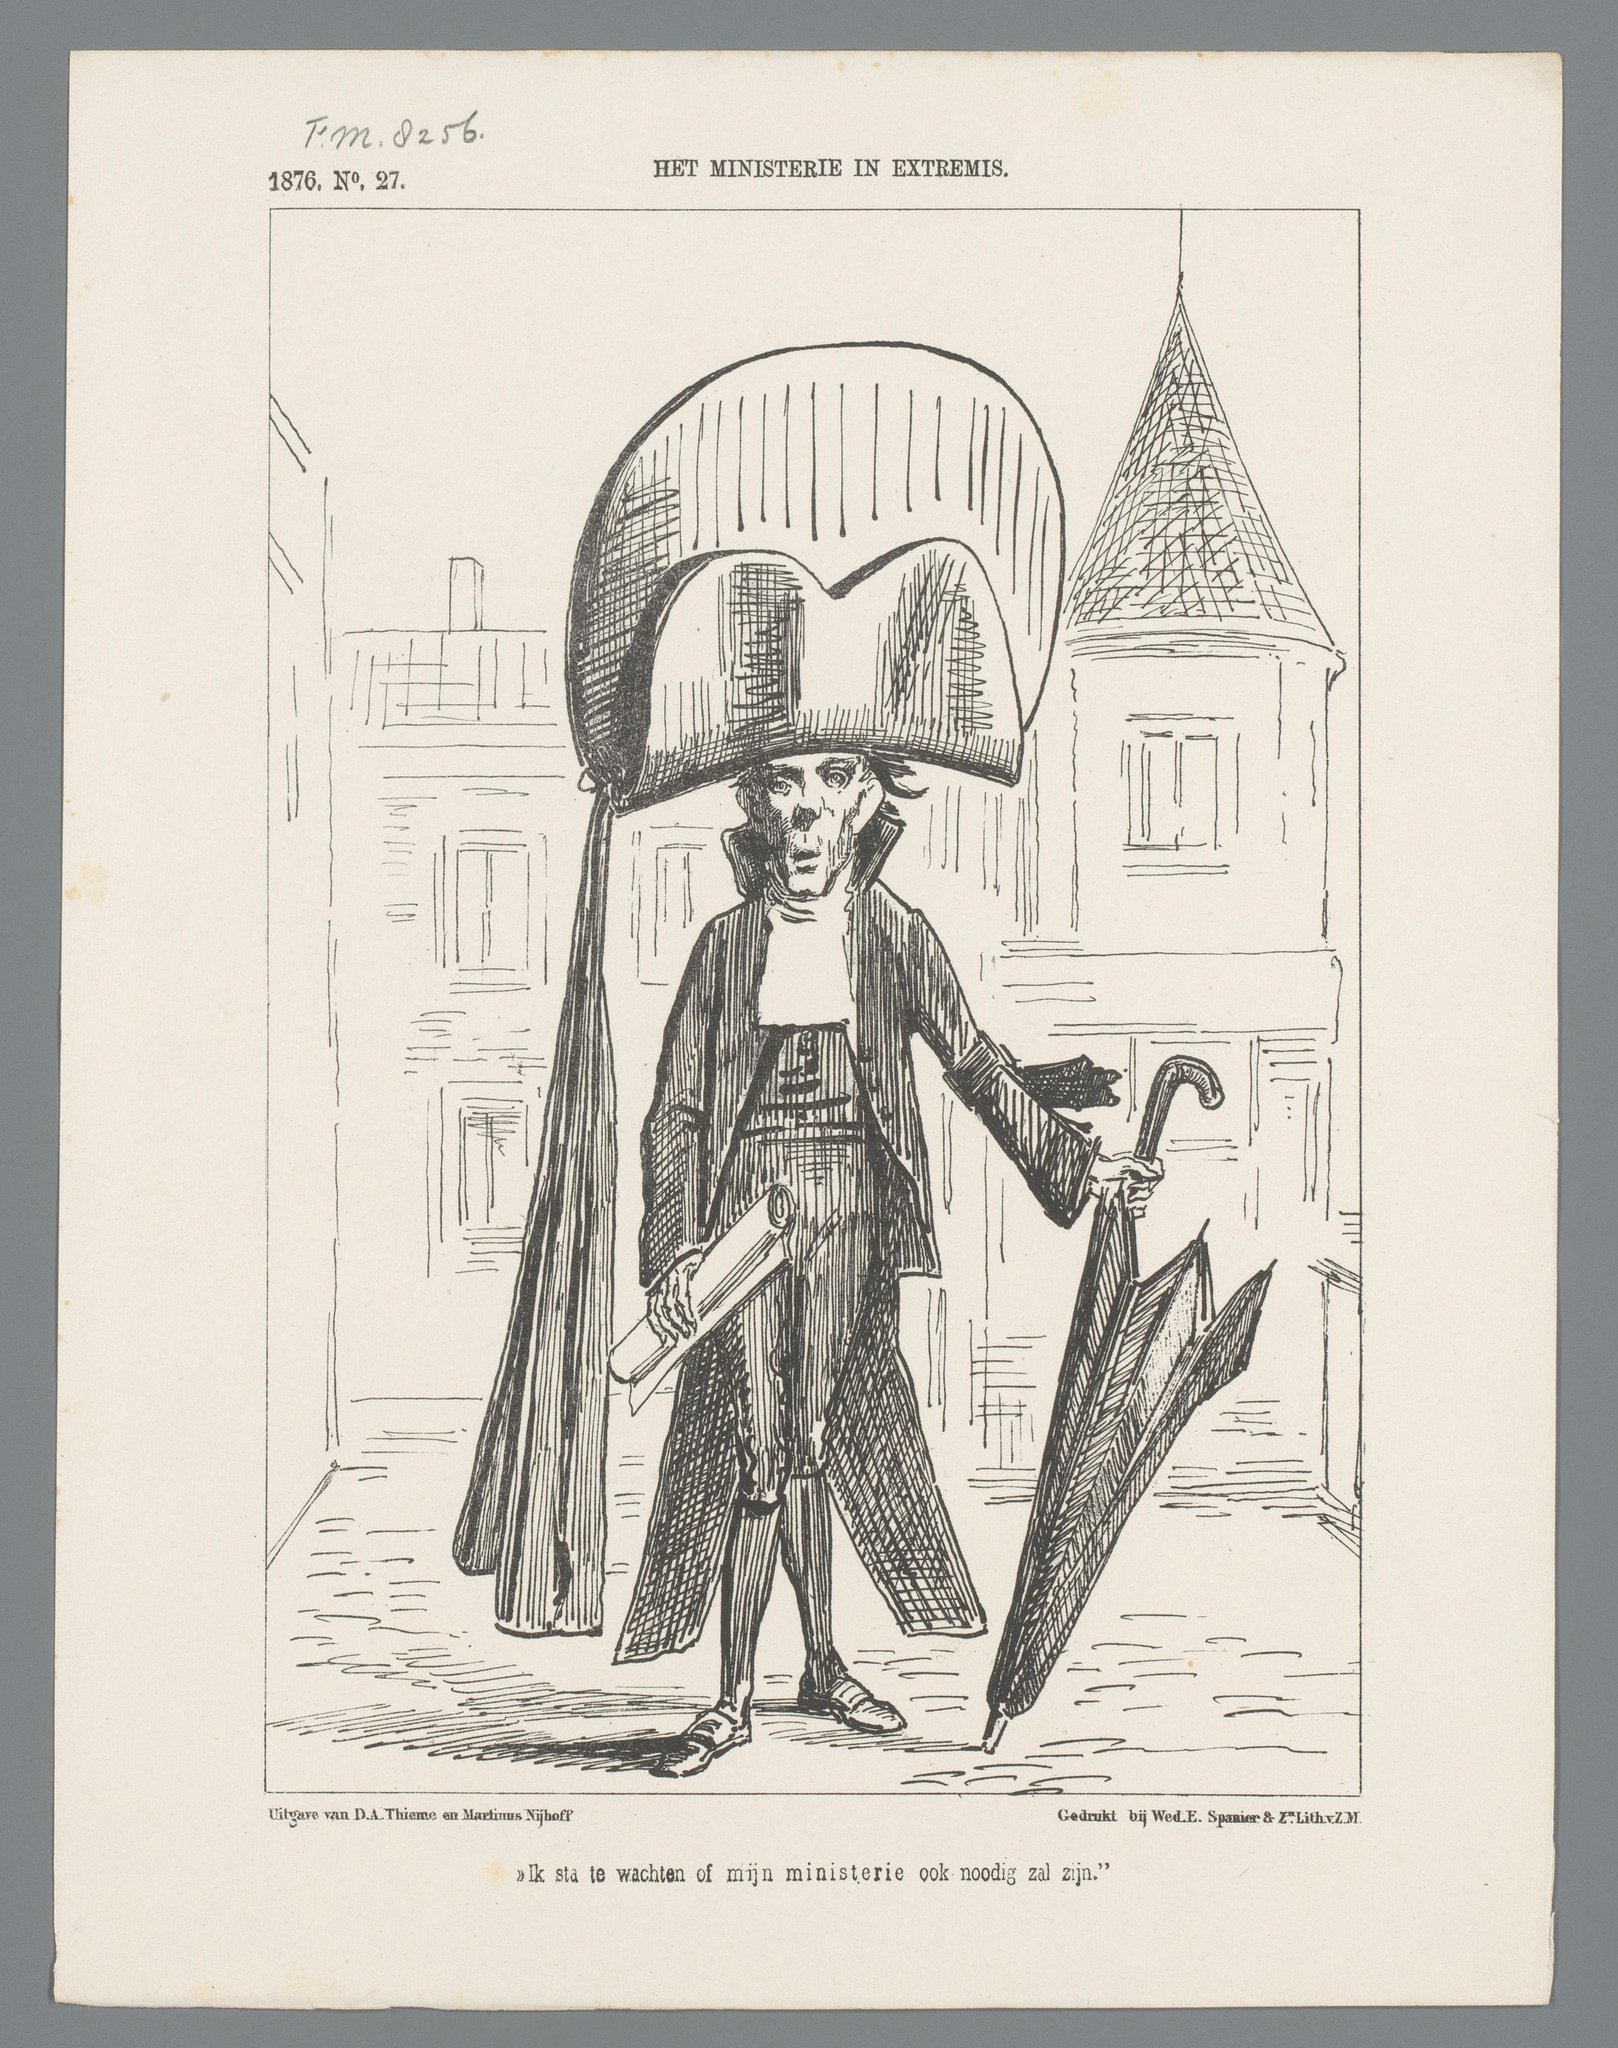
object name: print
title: Het ministerie in extremis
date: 1876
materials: paper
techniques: lithograph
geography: the hague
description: Spotprent . Plaat verschenen bij het weekblad De Nederlandsche Spectator, nr. 27, 1876.